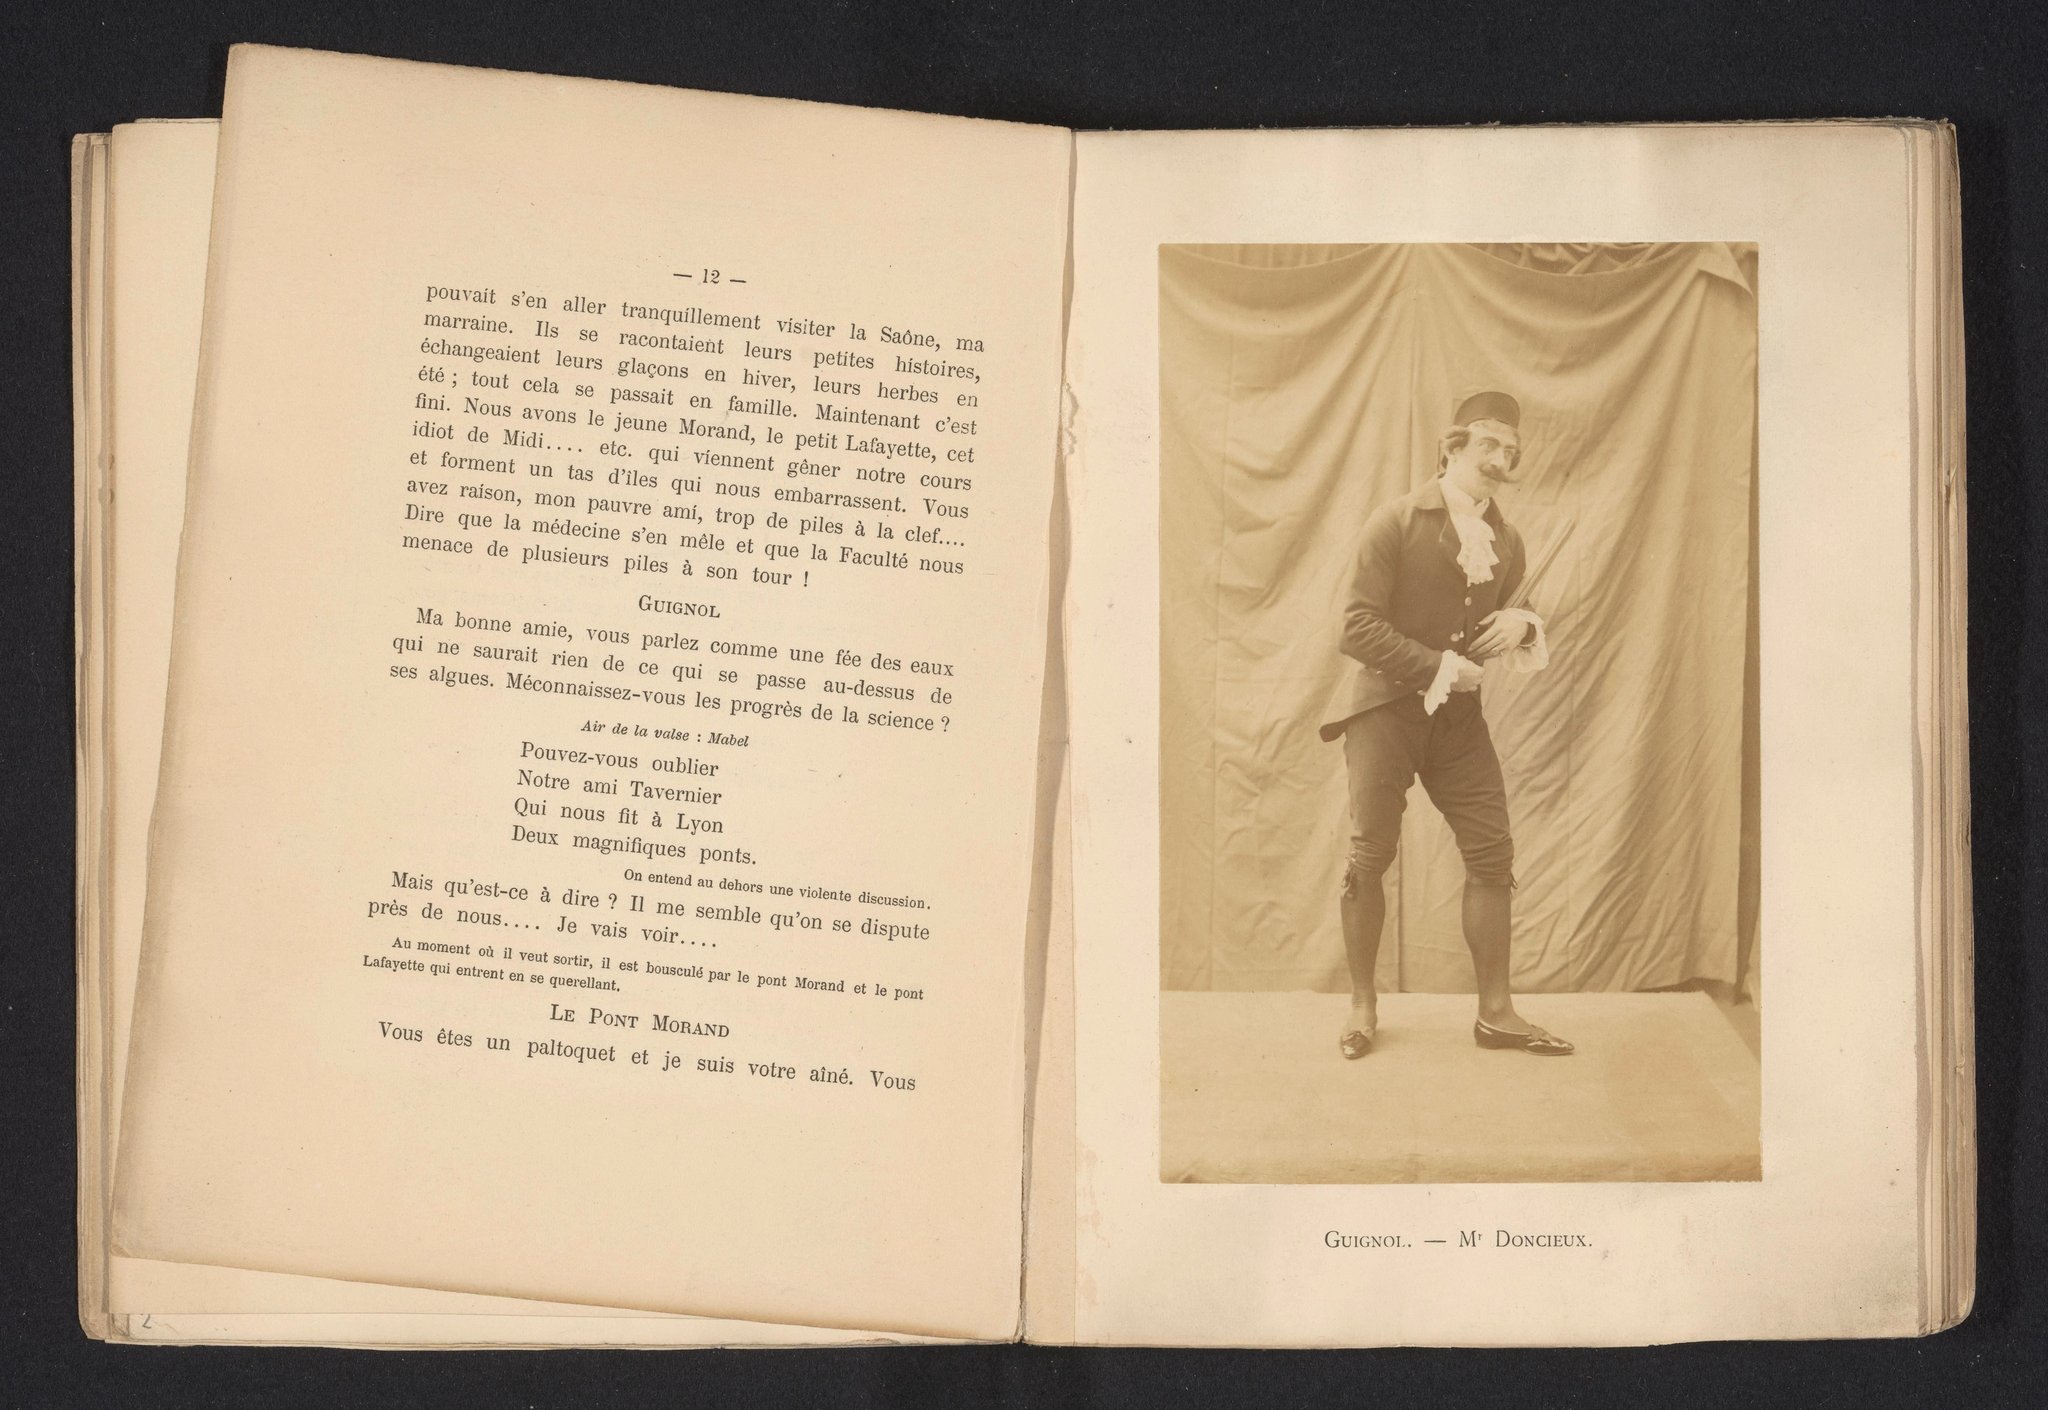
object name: page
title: Portret van de heer Doncieux verkleed als Guignol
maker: Anonymous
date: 1803-1891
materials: photographic support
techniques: albumen print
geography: lyon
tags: actor (on the stage)